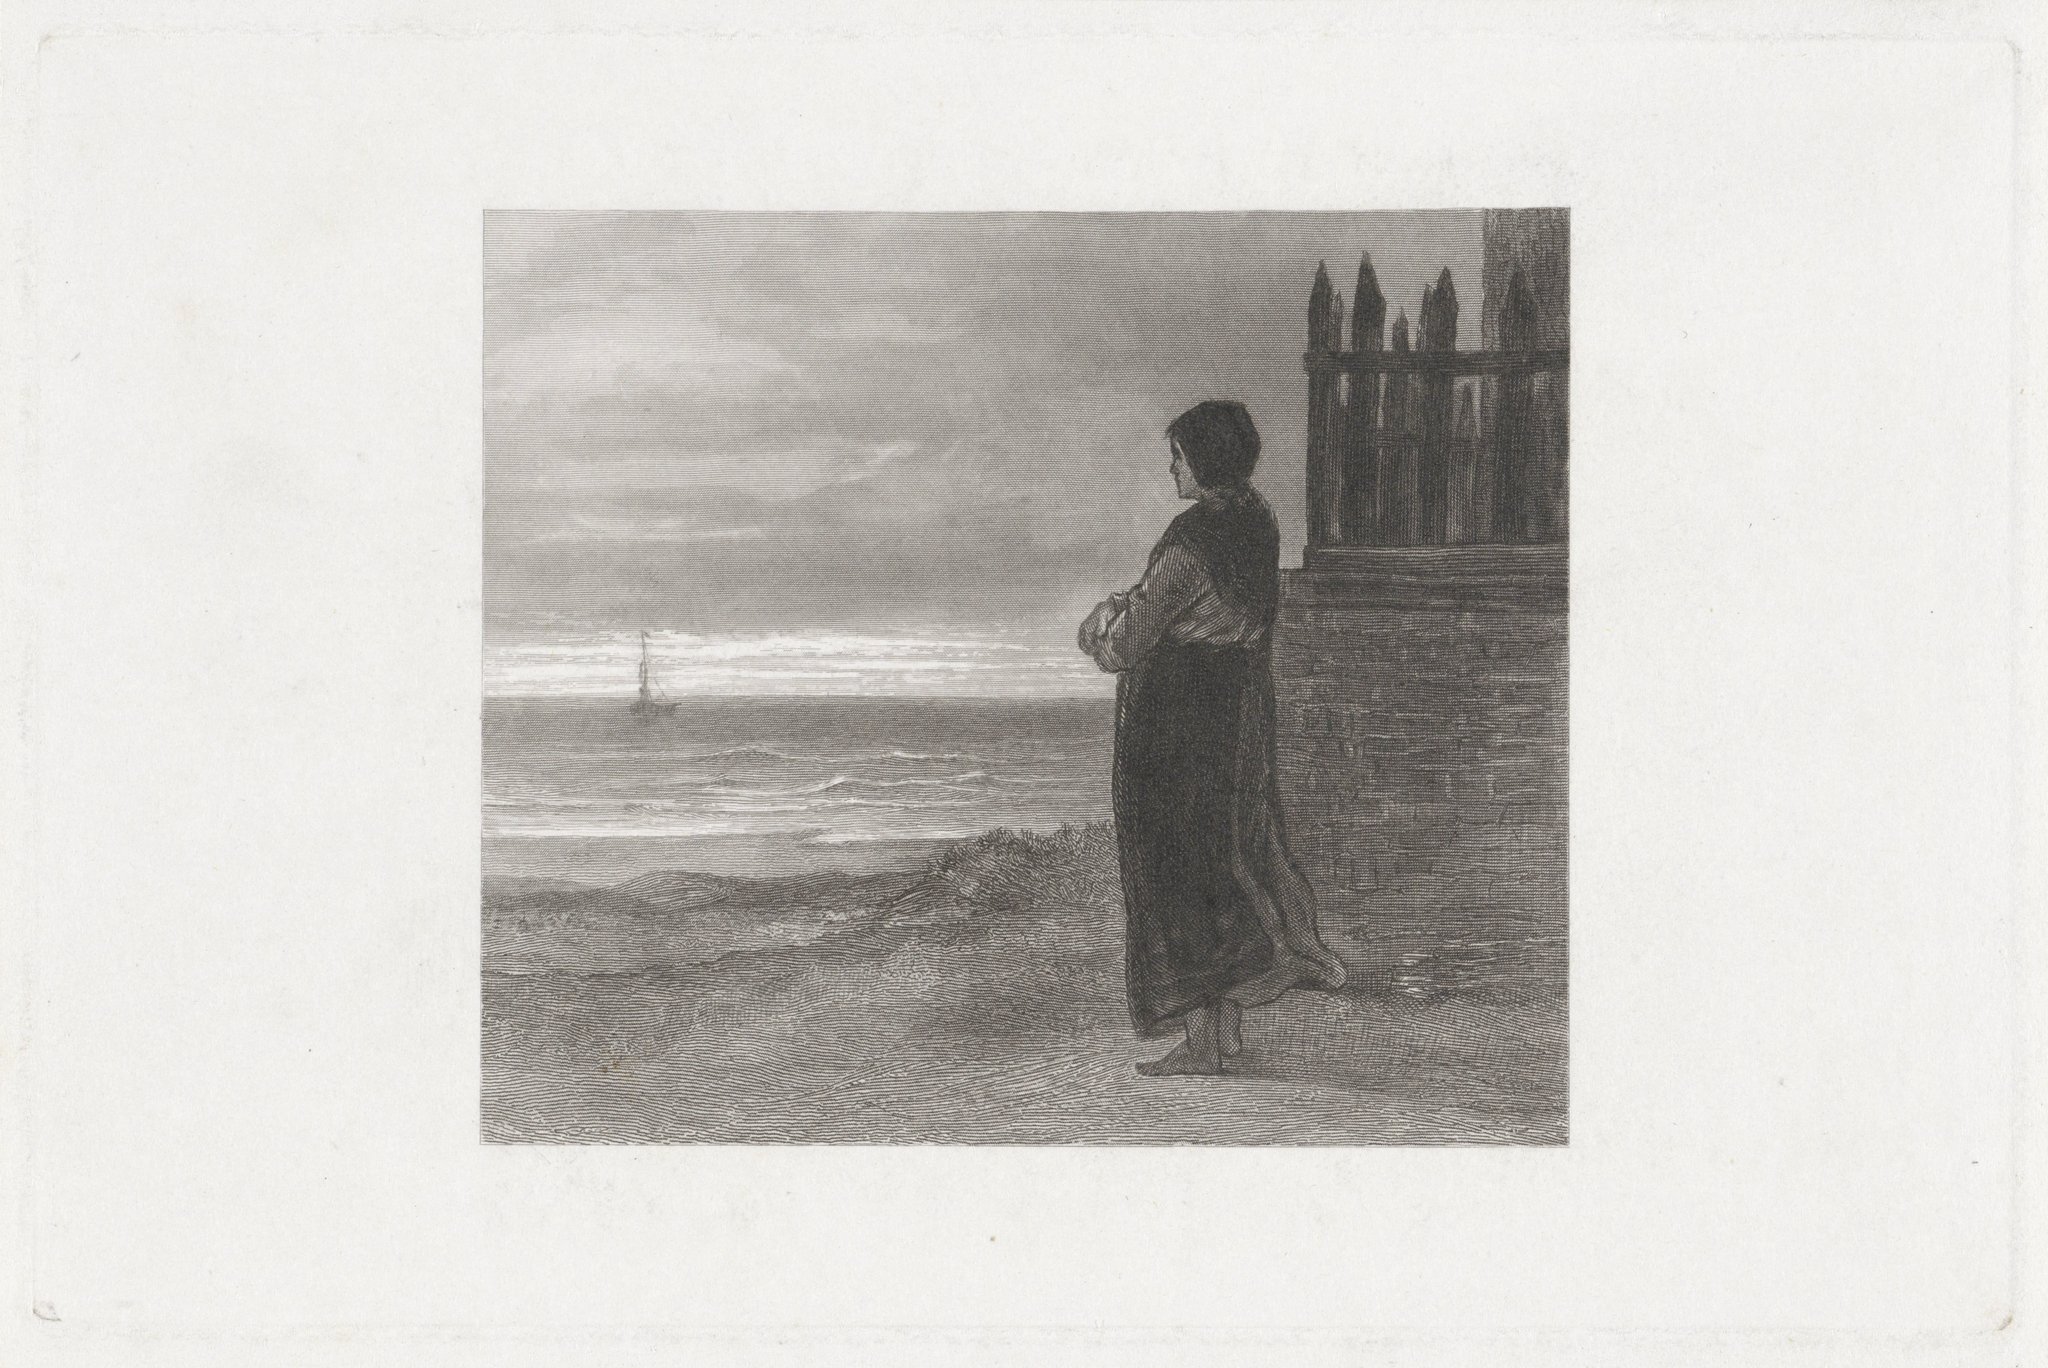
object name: print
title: Eenzame visservrouw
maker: dirk jurriaan sluyter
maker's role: draughtsman, print maker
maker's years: 1811-1886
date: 1826-1886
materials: paper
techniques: etching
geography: amsterdam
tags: fisherman (+ variant)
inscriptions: collector's mark: Lugt 2228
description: Een vissersvrouw op blote voeten staat op het strand en staart naar zee.